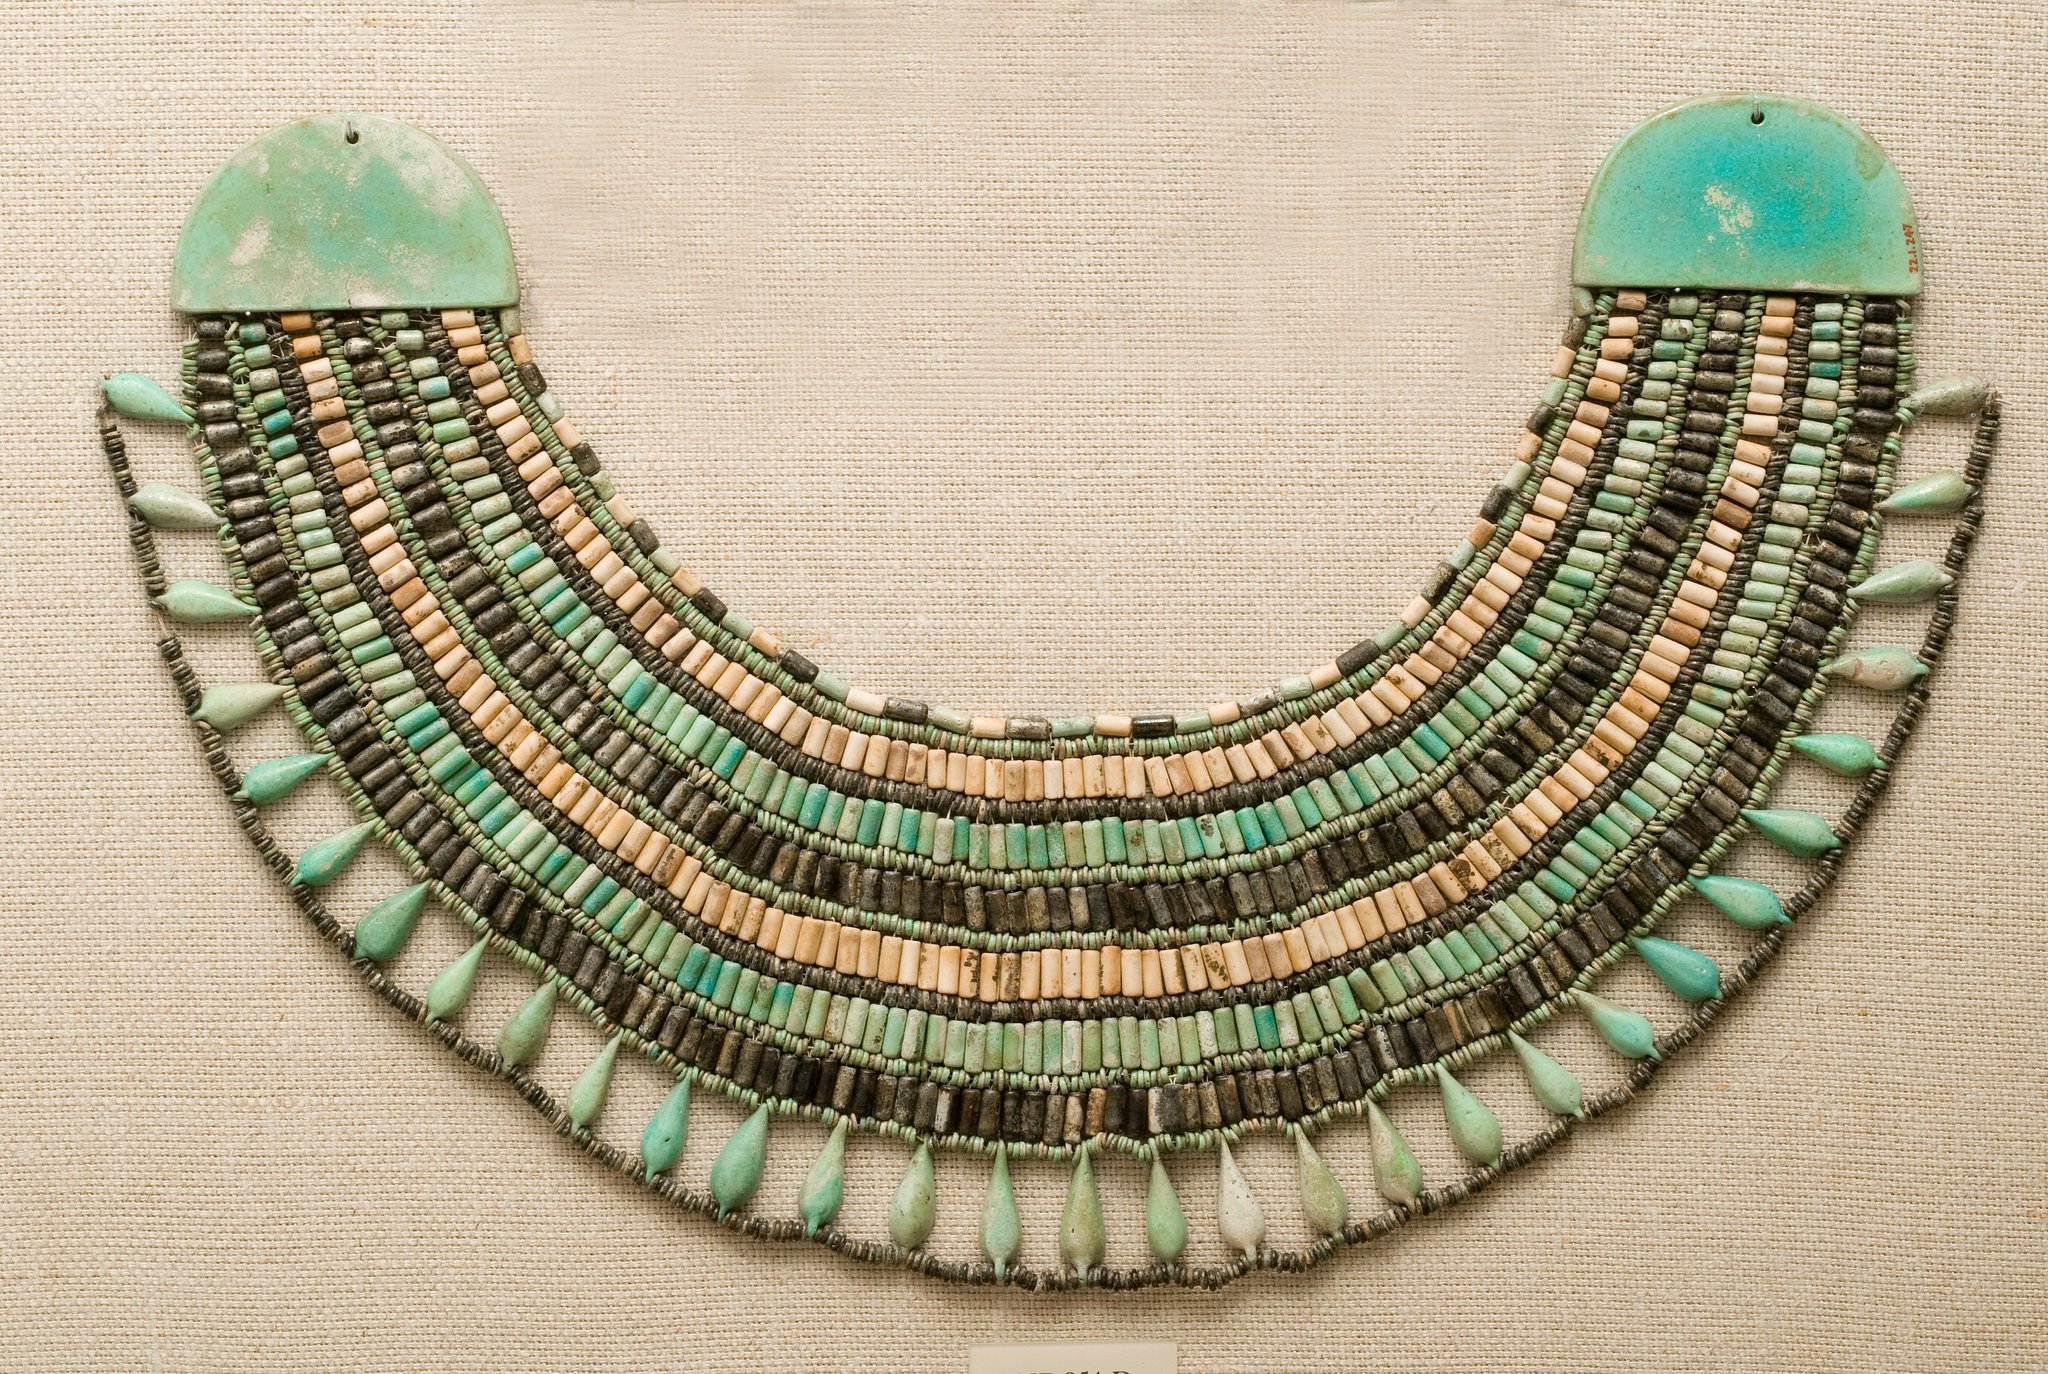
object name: broad collar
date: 1950-1900 BCE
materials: faience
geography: egypt